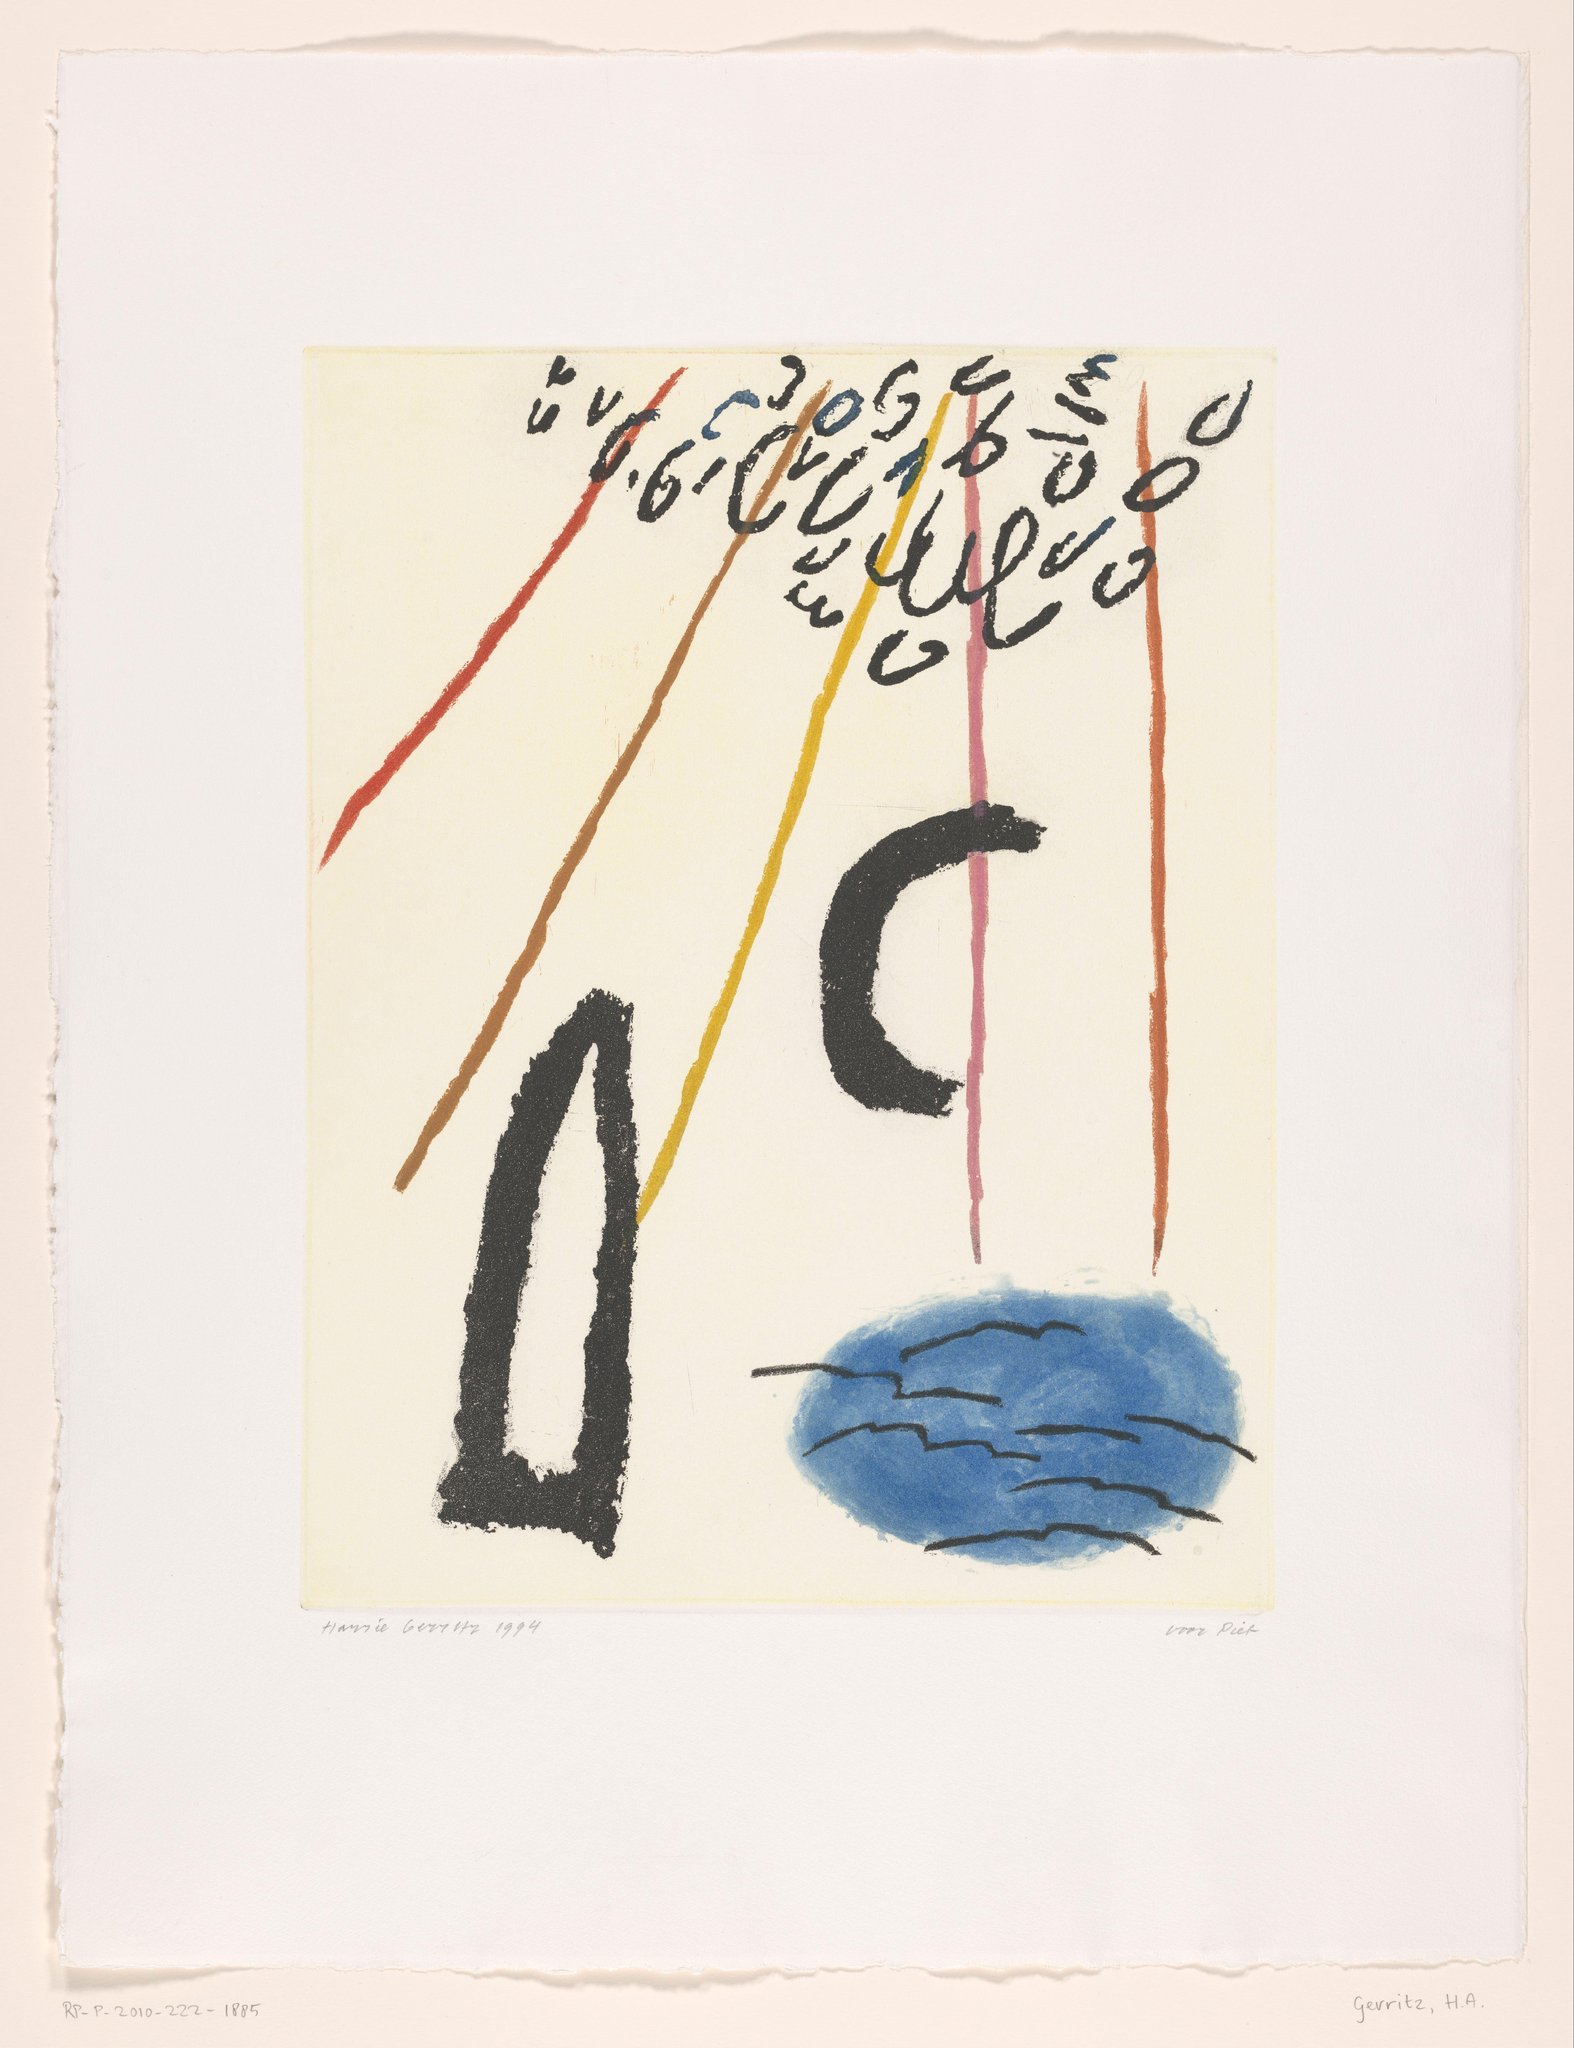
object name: print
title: Abstracte compositie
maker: harrie a. gerritz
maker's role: draughtsman, painter, print maker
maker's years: 1940-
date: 1994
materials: paper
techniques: aquatint, intaglio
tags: abstract, non-representational art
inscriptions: dedication: ‘voor Piet’, inscription: ‘PC’, watermark:, collector's mark: Lugt 2228